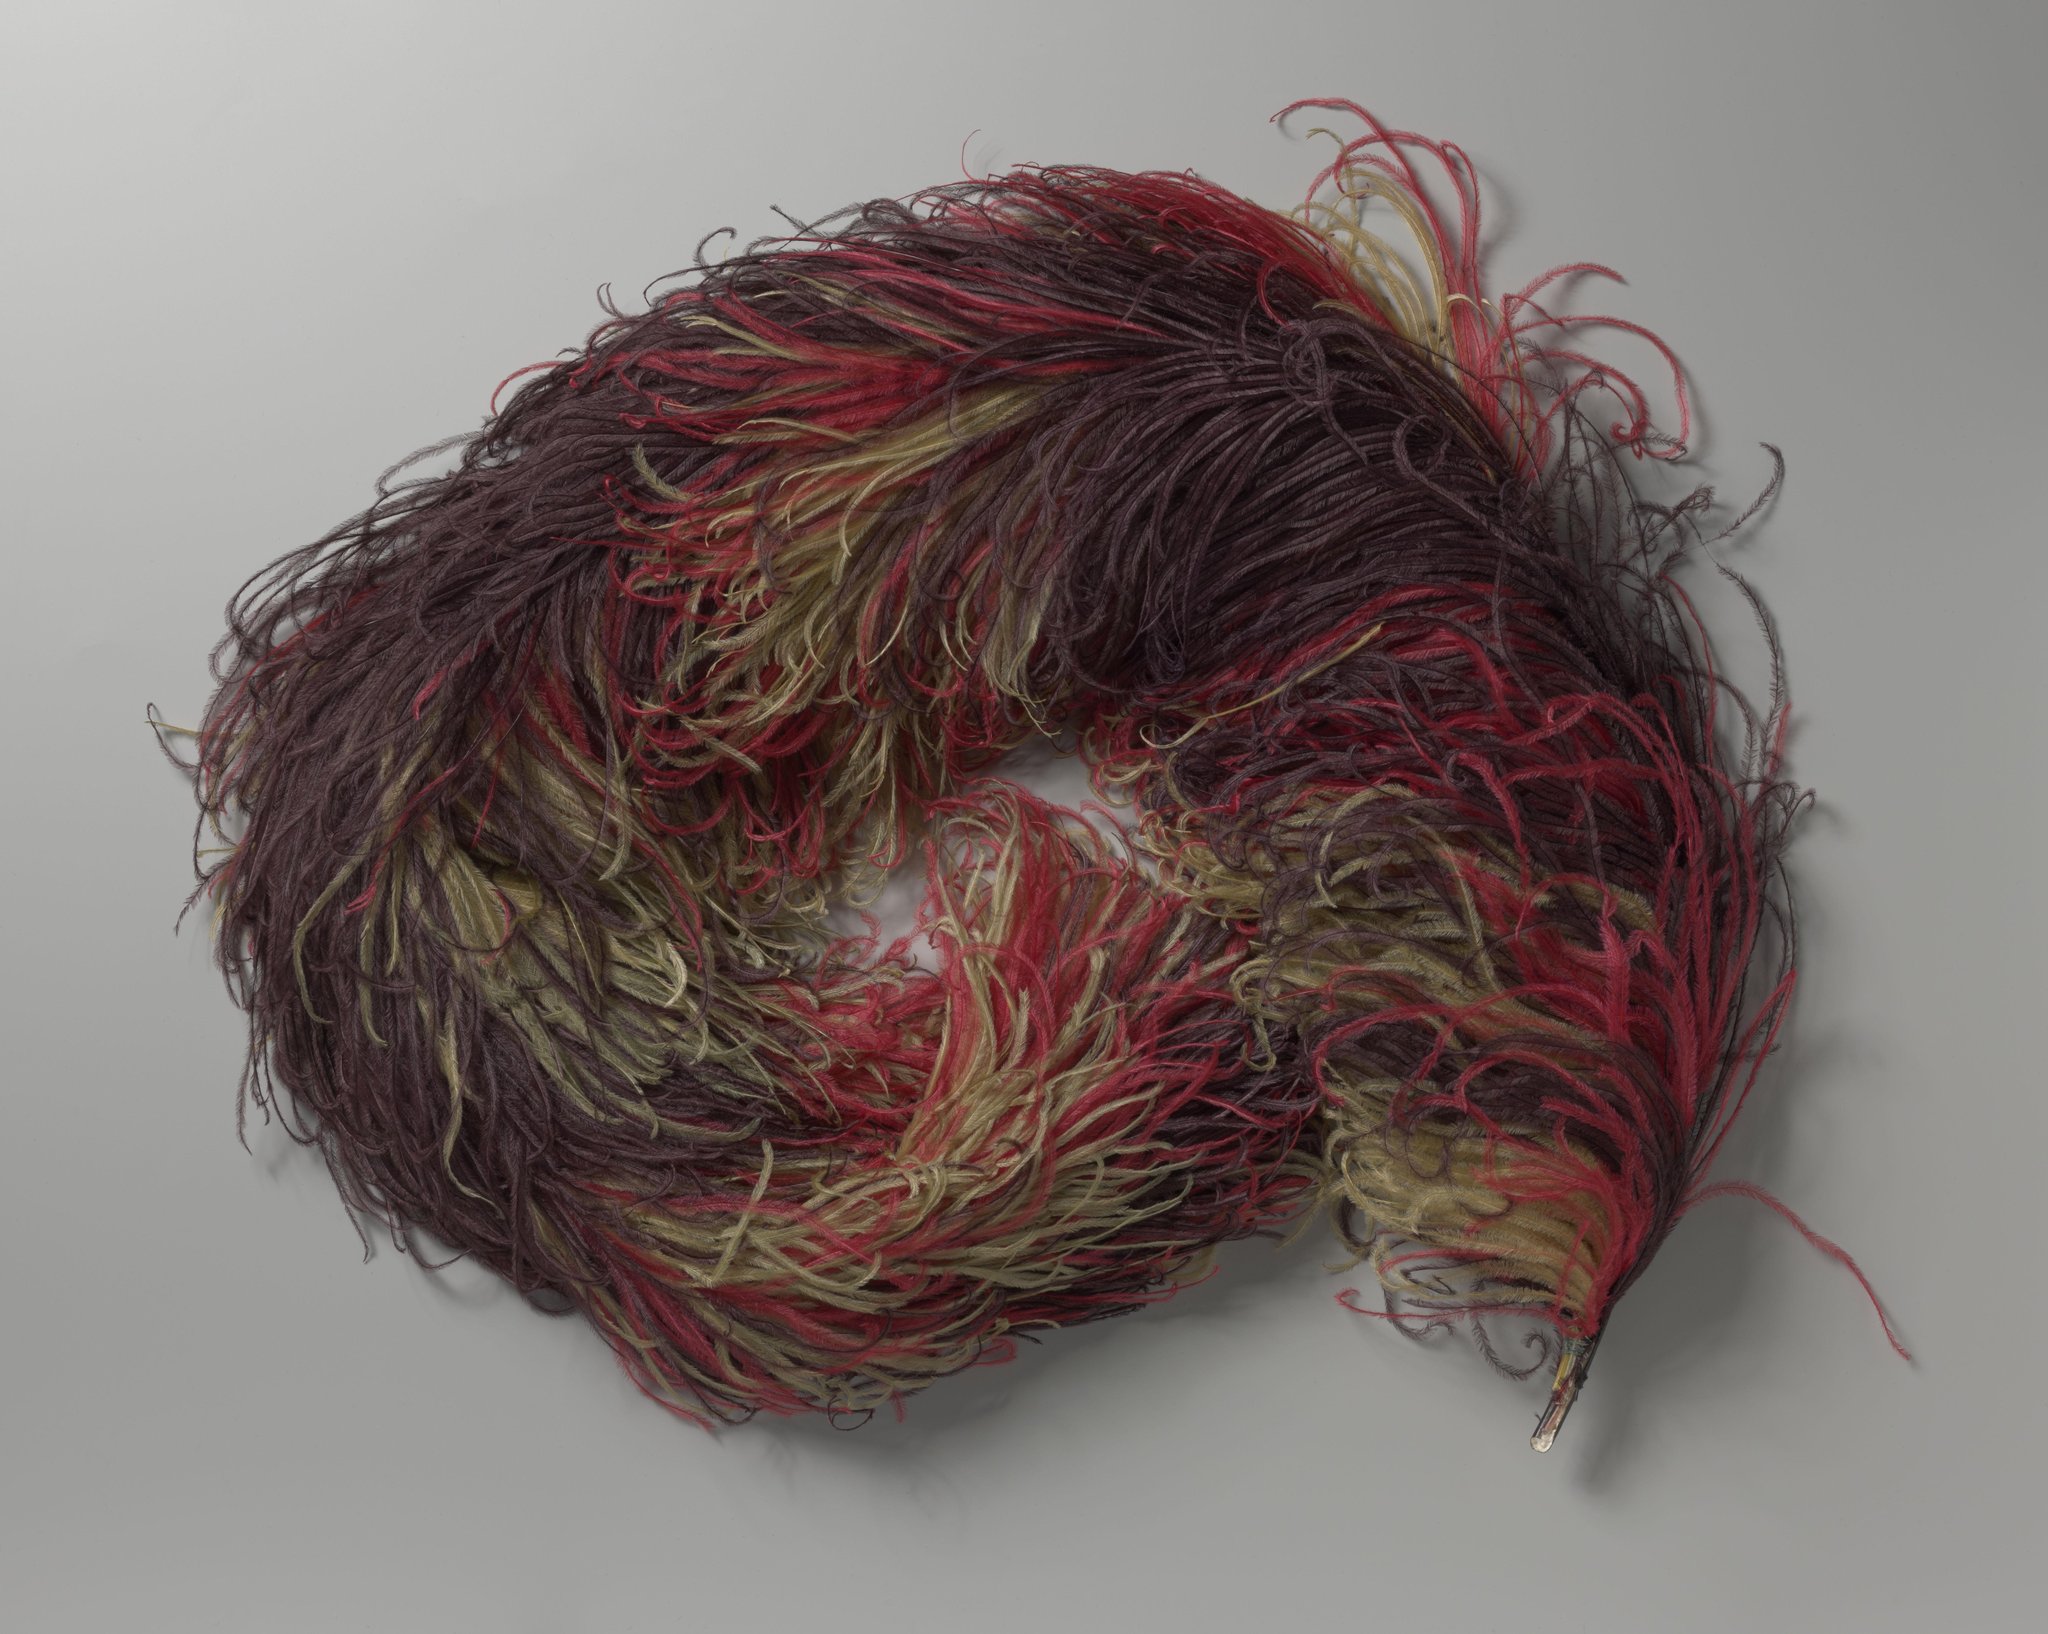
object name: hoedengarneersel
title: Struisveer, rond, in de kleuren paars, rood en groen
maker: Anonymous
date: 1895-1915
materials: ostrich feather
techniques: painting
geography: western europe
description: Een grote ronde struisveer in gemengd paars, rood en groen.